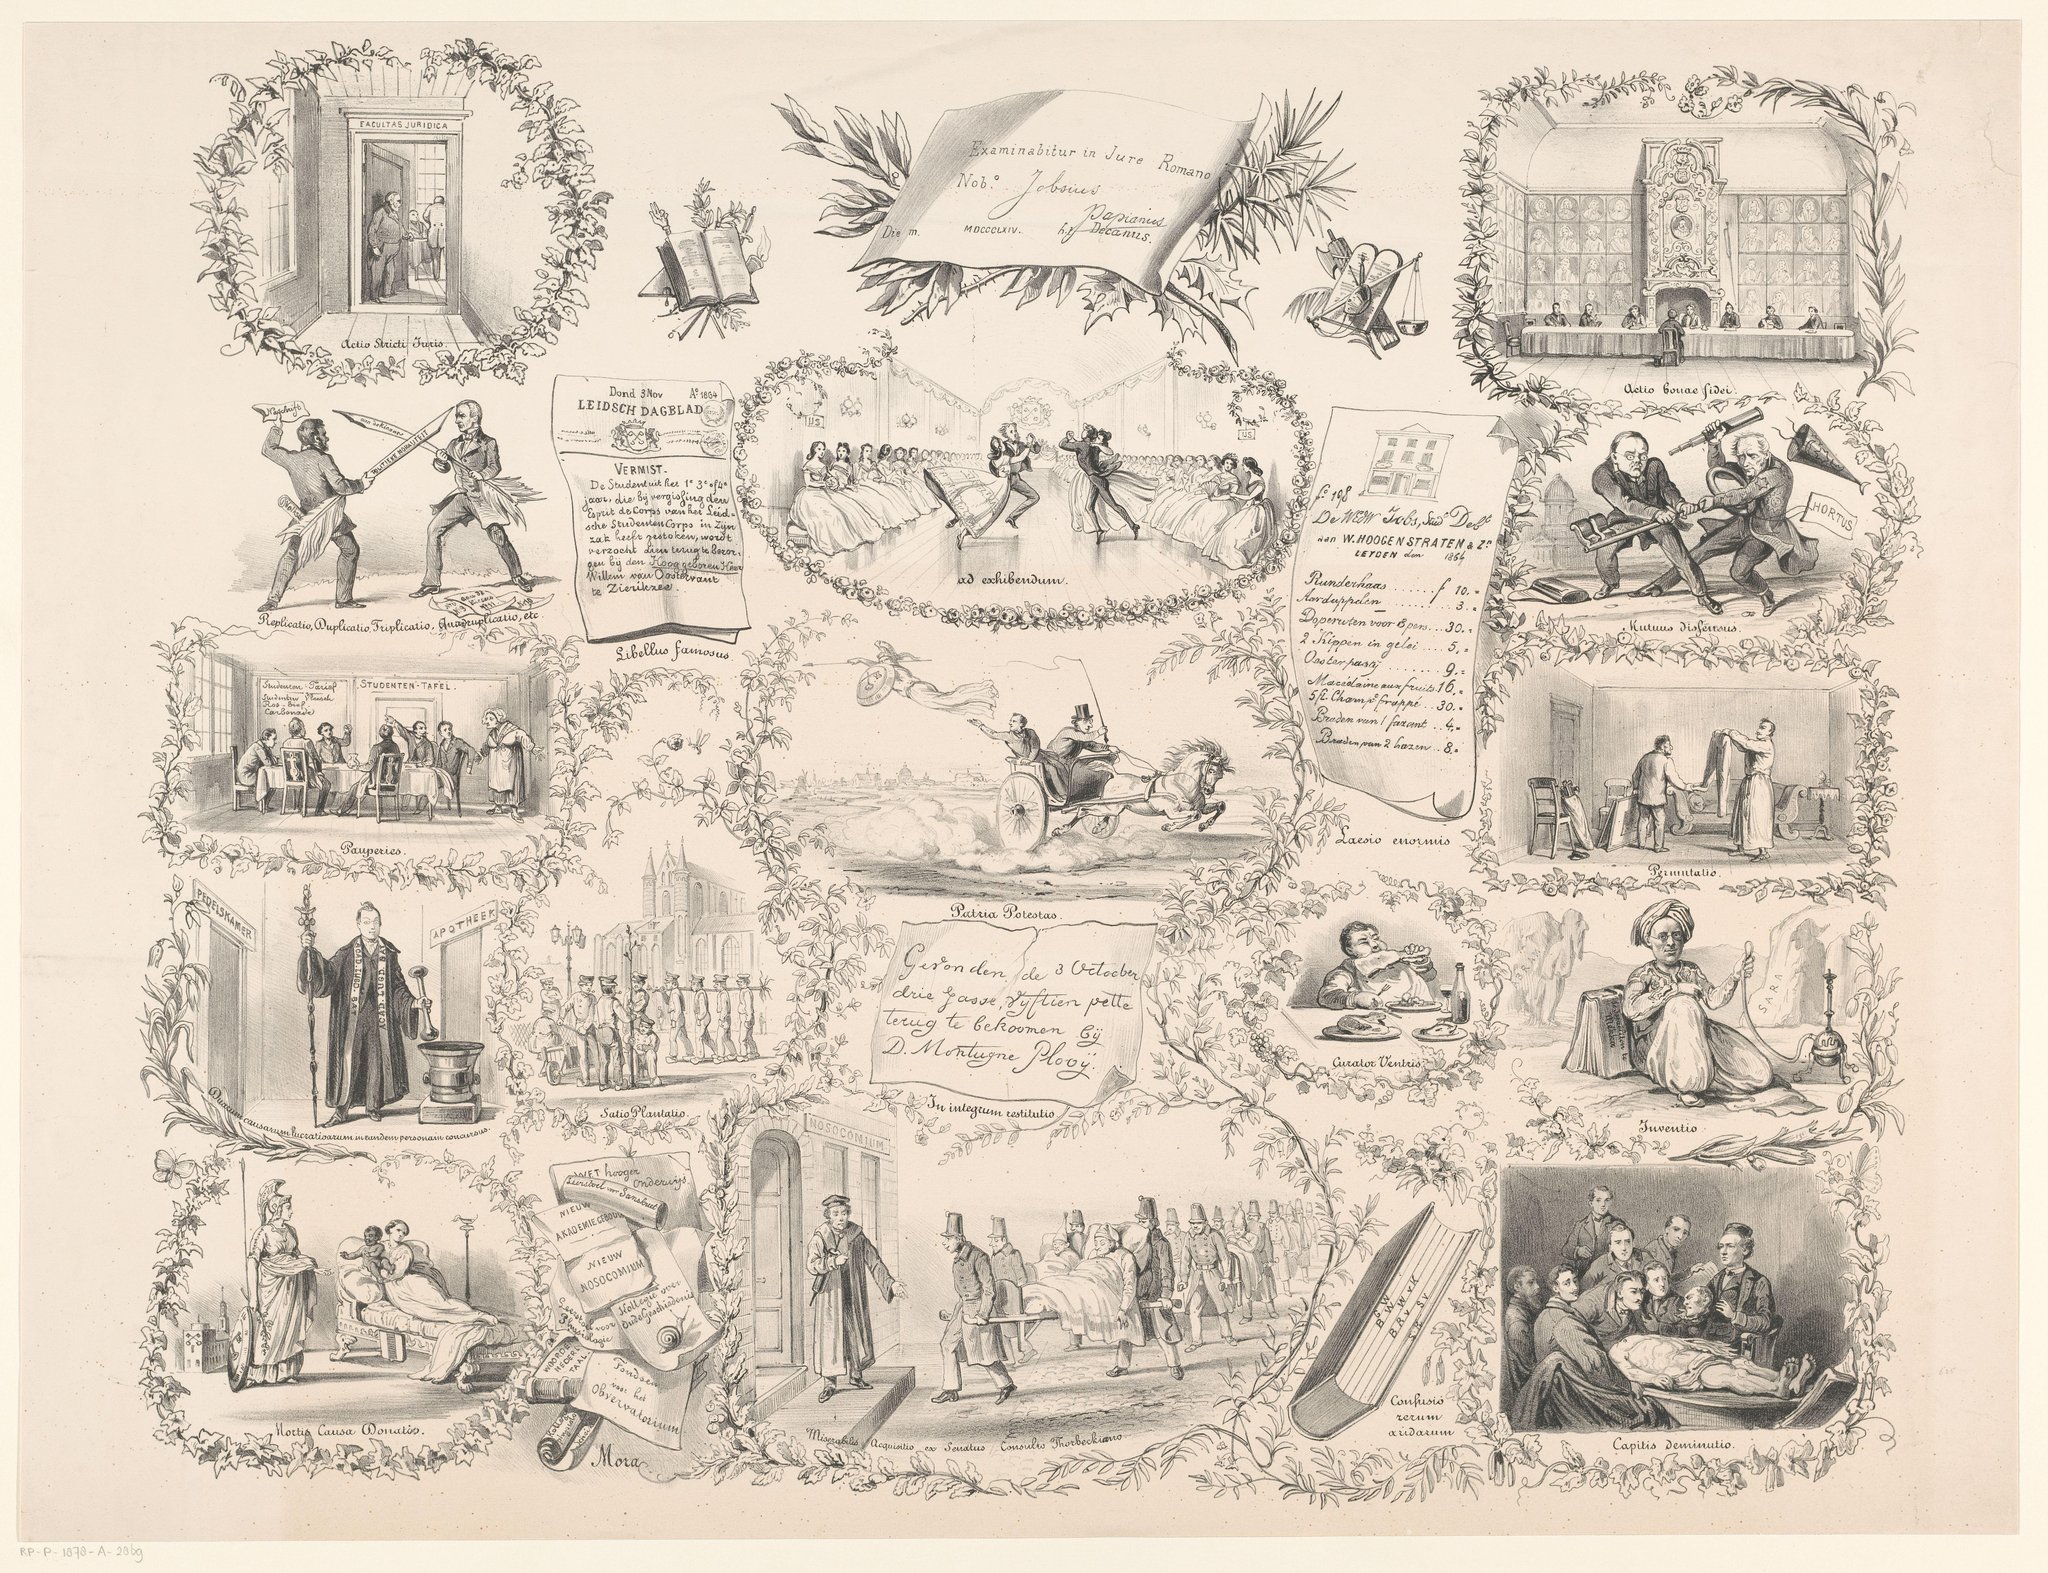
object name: print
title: Spotprent met scènes uit het studentenleven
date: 1865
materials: paper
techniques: lithograph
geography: leiden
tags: student life, leiden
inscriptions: collector's mark: Lugt 2228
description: Spotprent in Leidse studentenalmanak, 1865.